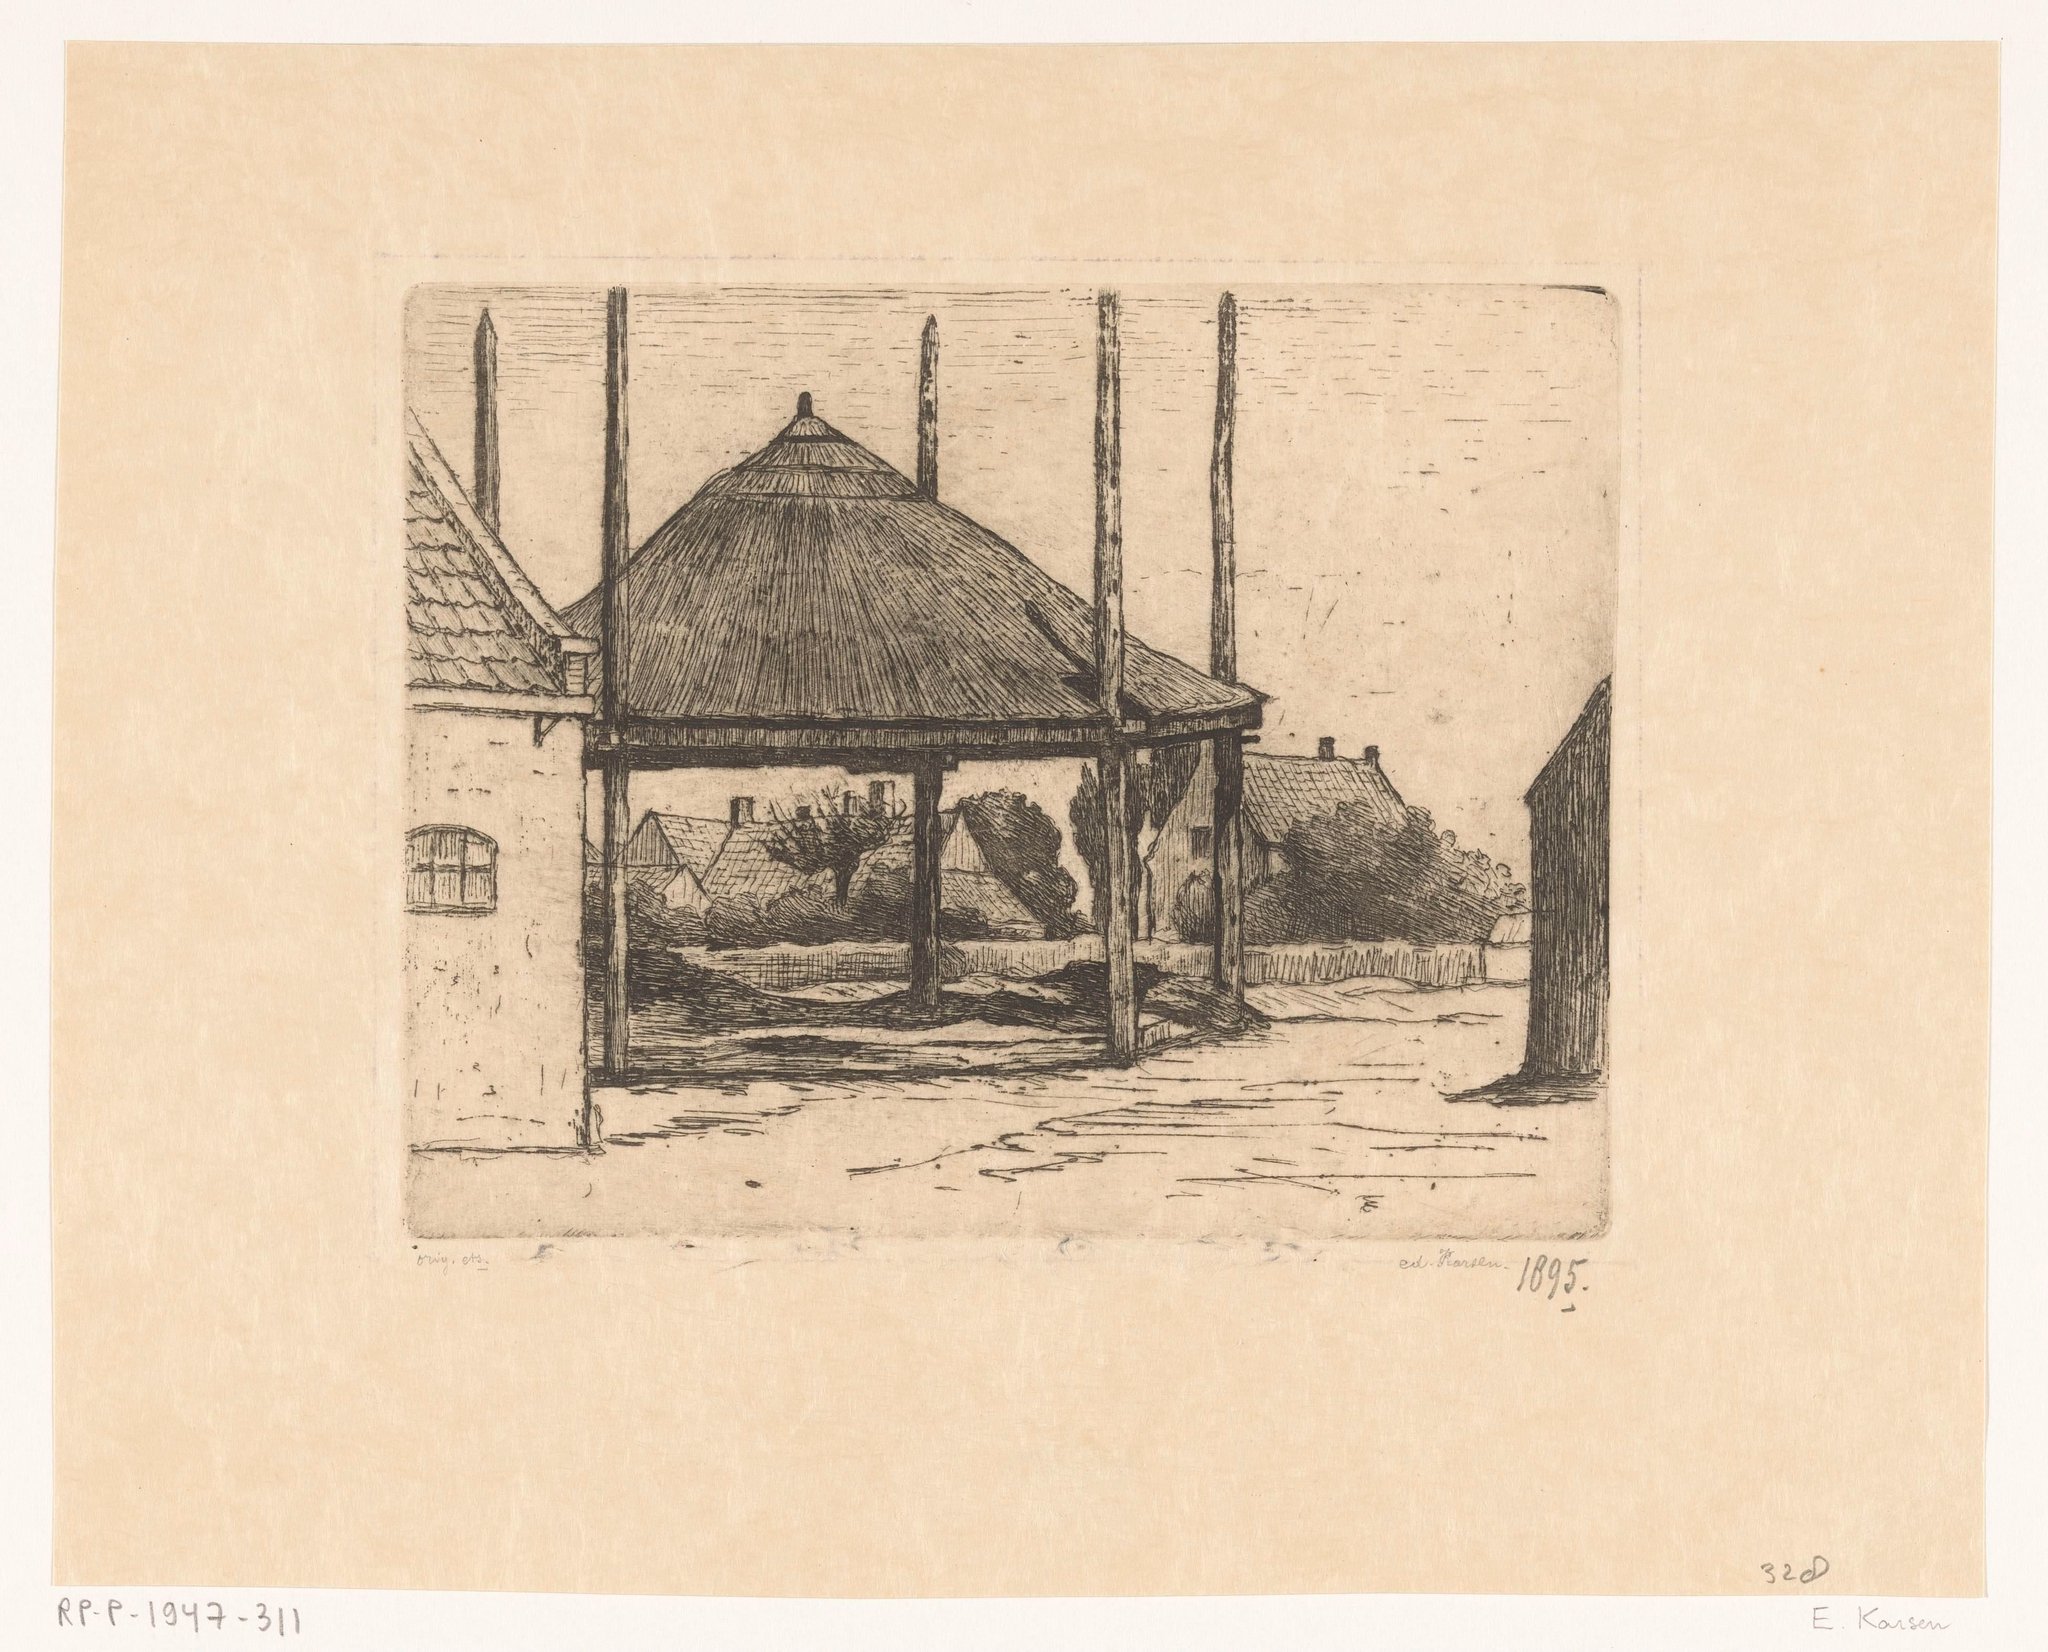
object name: print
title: Boerenerf met lege hooischuur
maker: eduard karsen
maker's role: draughtsman, painter, print maker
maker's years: 1860-1941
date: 1895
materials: paper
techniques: etching, intaglio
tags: barn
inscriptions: collector's mark: Lugt 2228